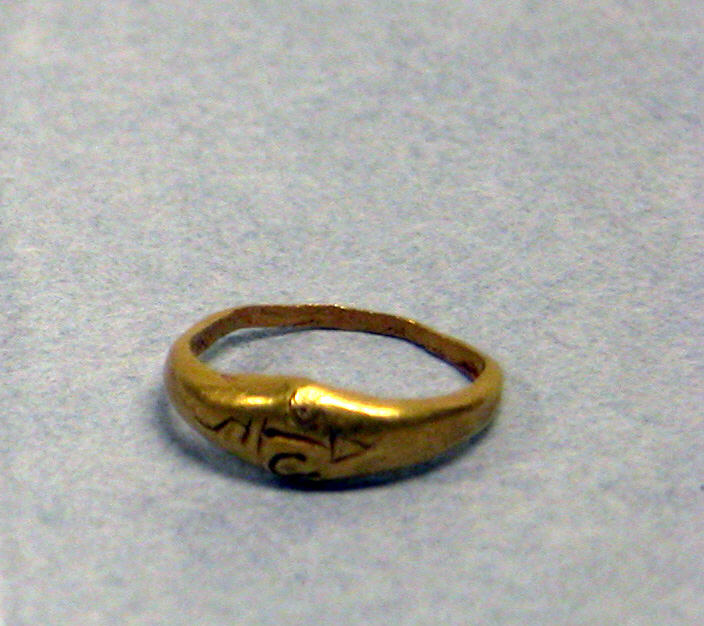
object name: ring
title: Engraved Ring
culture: indonesian, central java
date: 701-1200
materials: gold